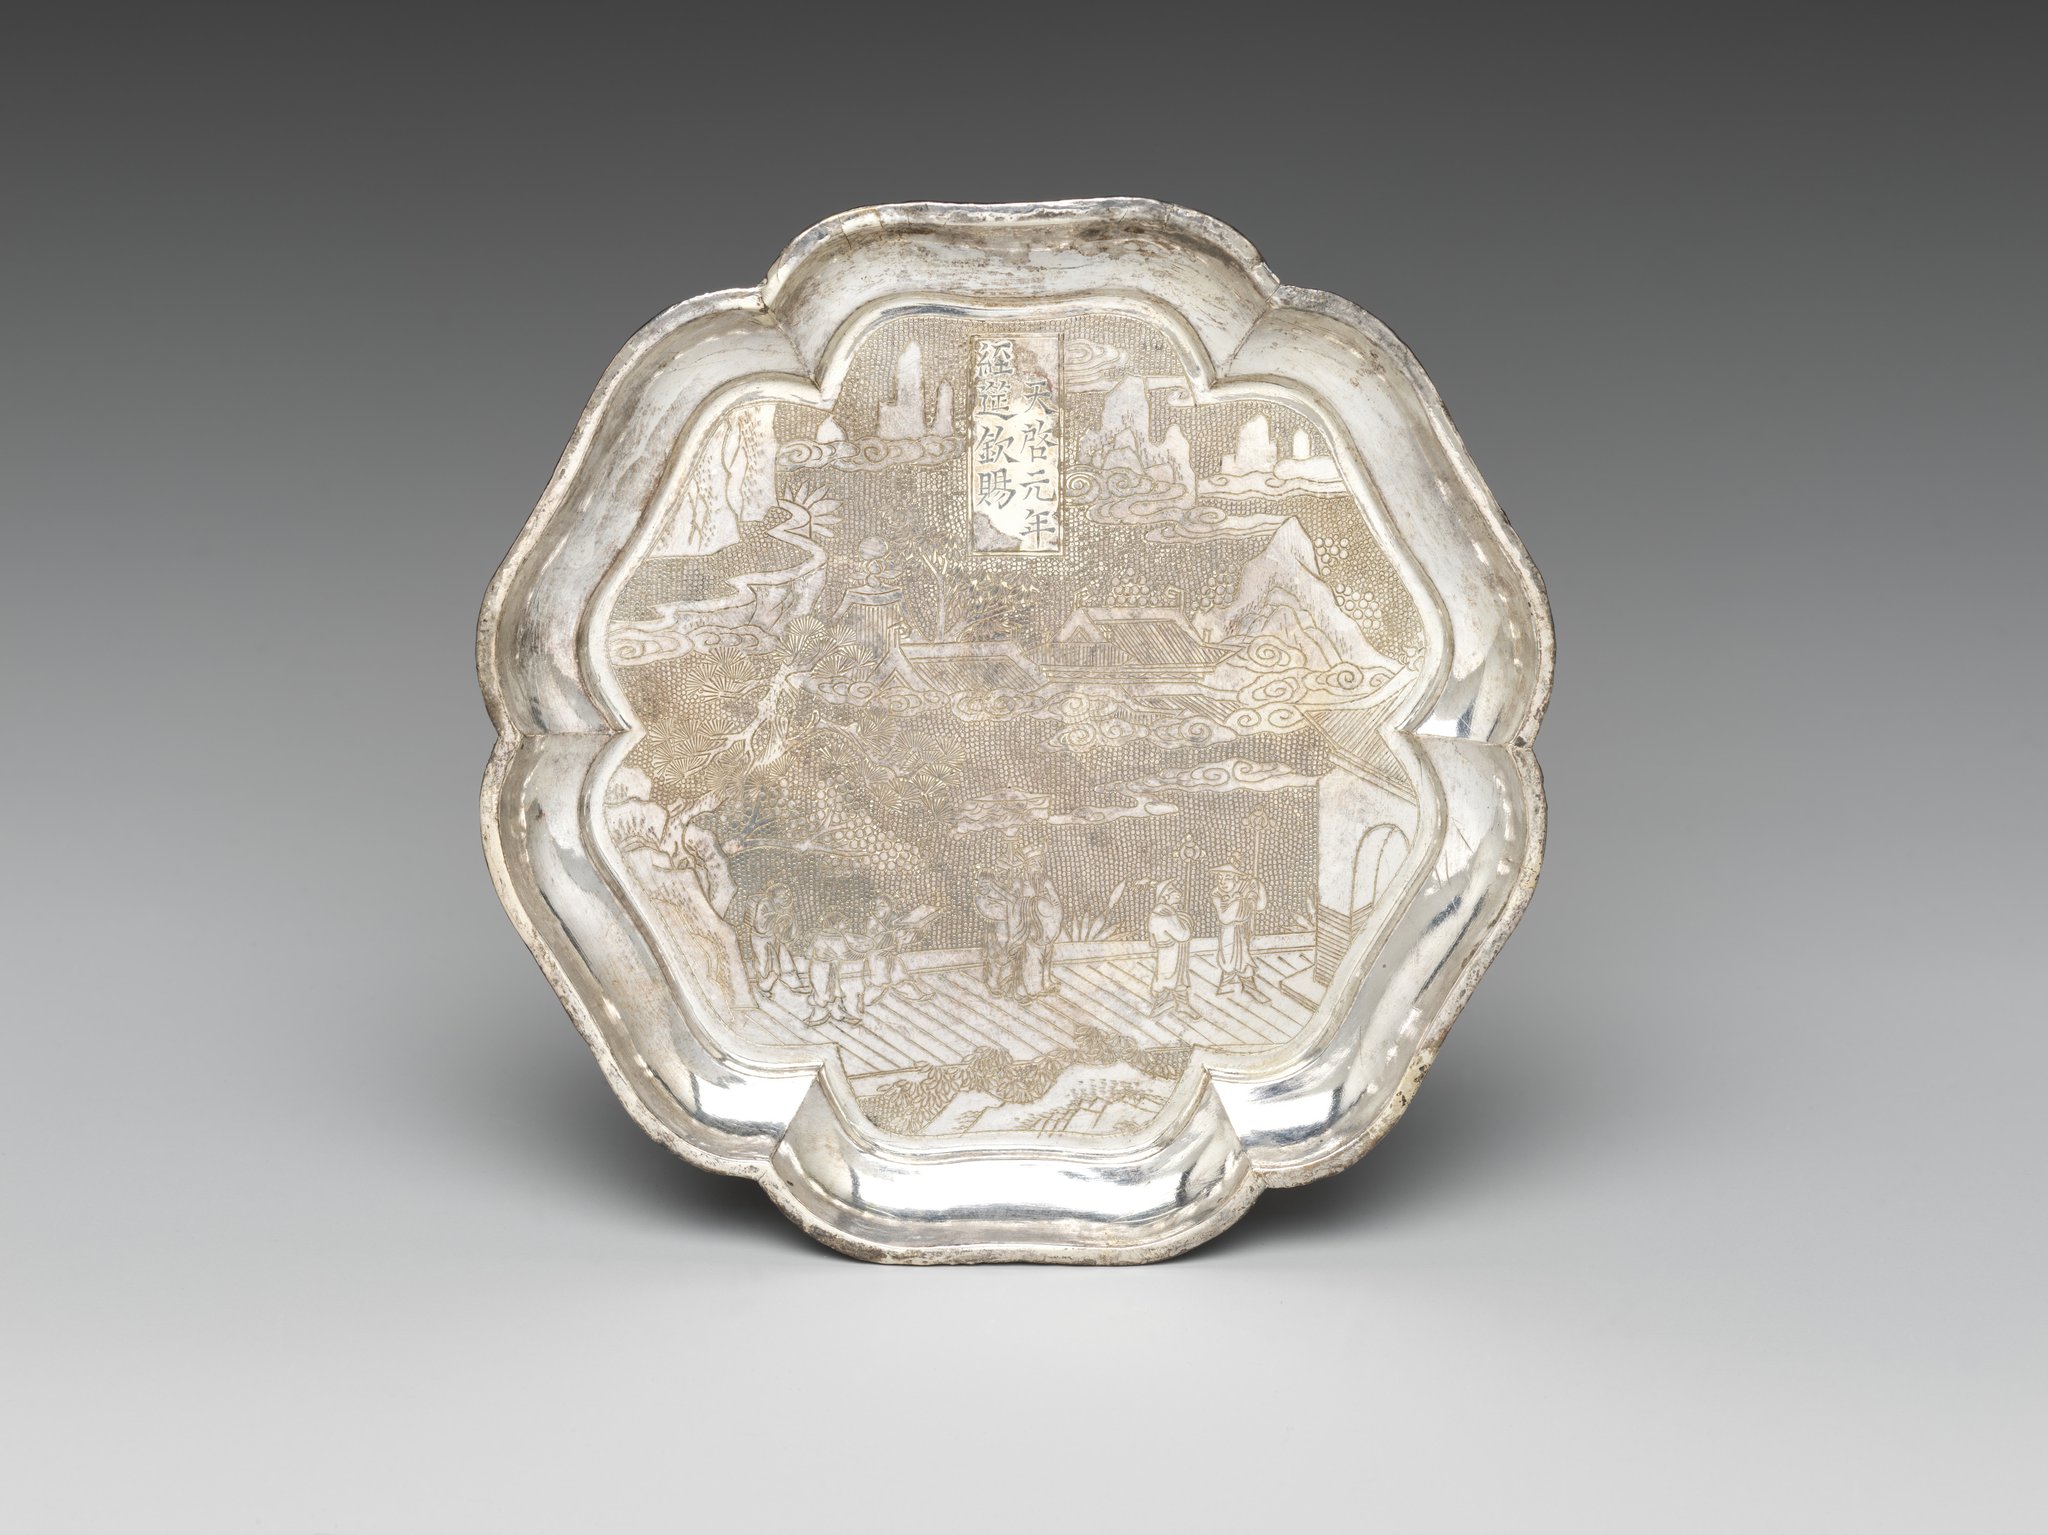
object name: dish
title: Presentation dish for an imperial lecture1621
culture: chinese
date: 1621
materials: silver